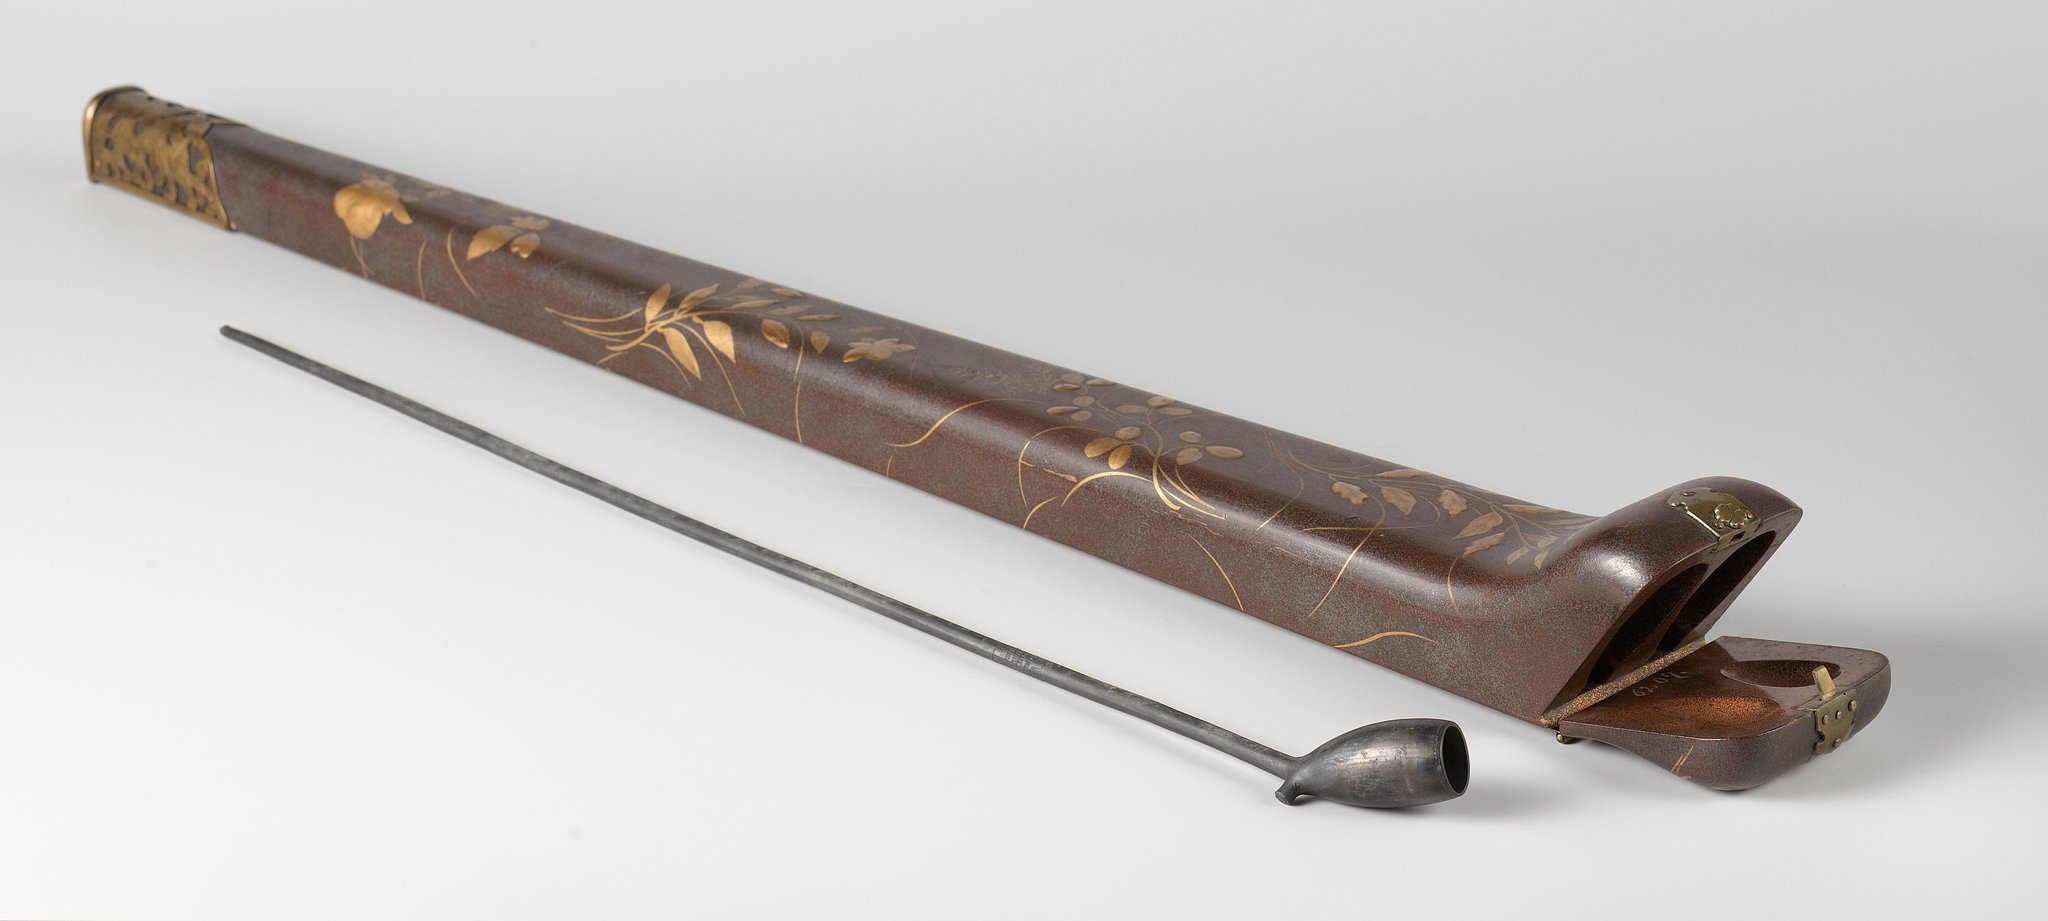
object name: pipe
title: Pijp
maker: Anonymous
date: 1700-1740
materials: clay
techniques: firing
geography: japan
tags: japan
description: Pijp in Japans pijpfoedraal, onduidelijk of deze pijp bij de doos hoort. De pijp is gemerkt: Peter Berger uit Grenzhausen [Westerwald], actief 1734-1771).